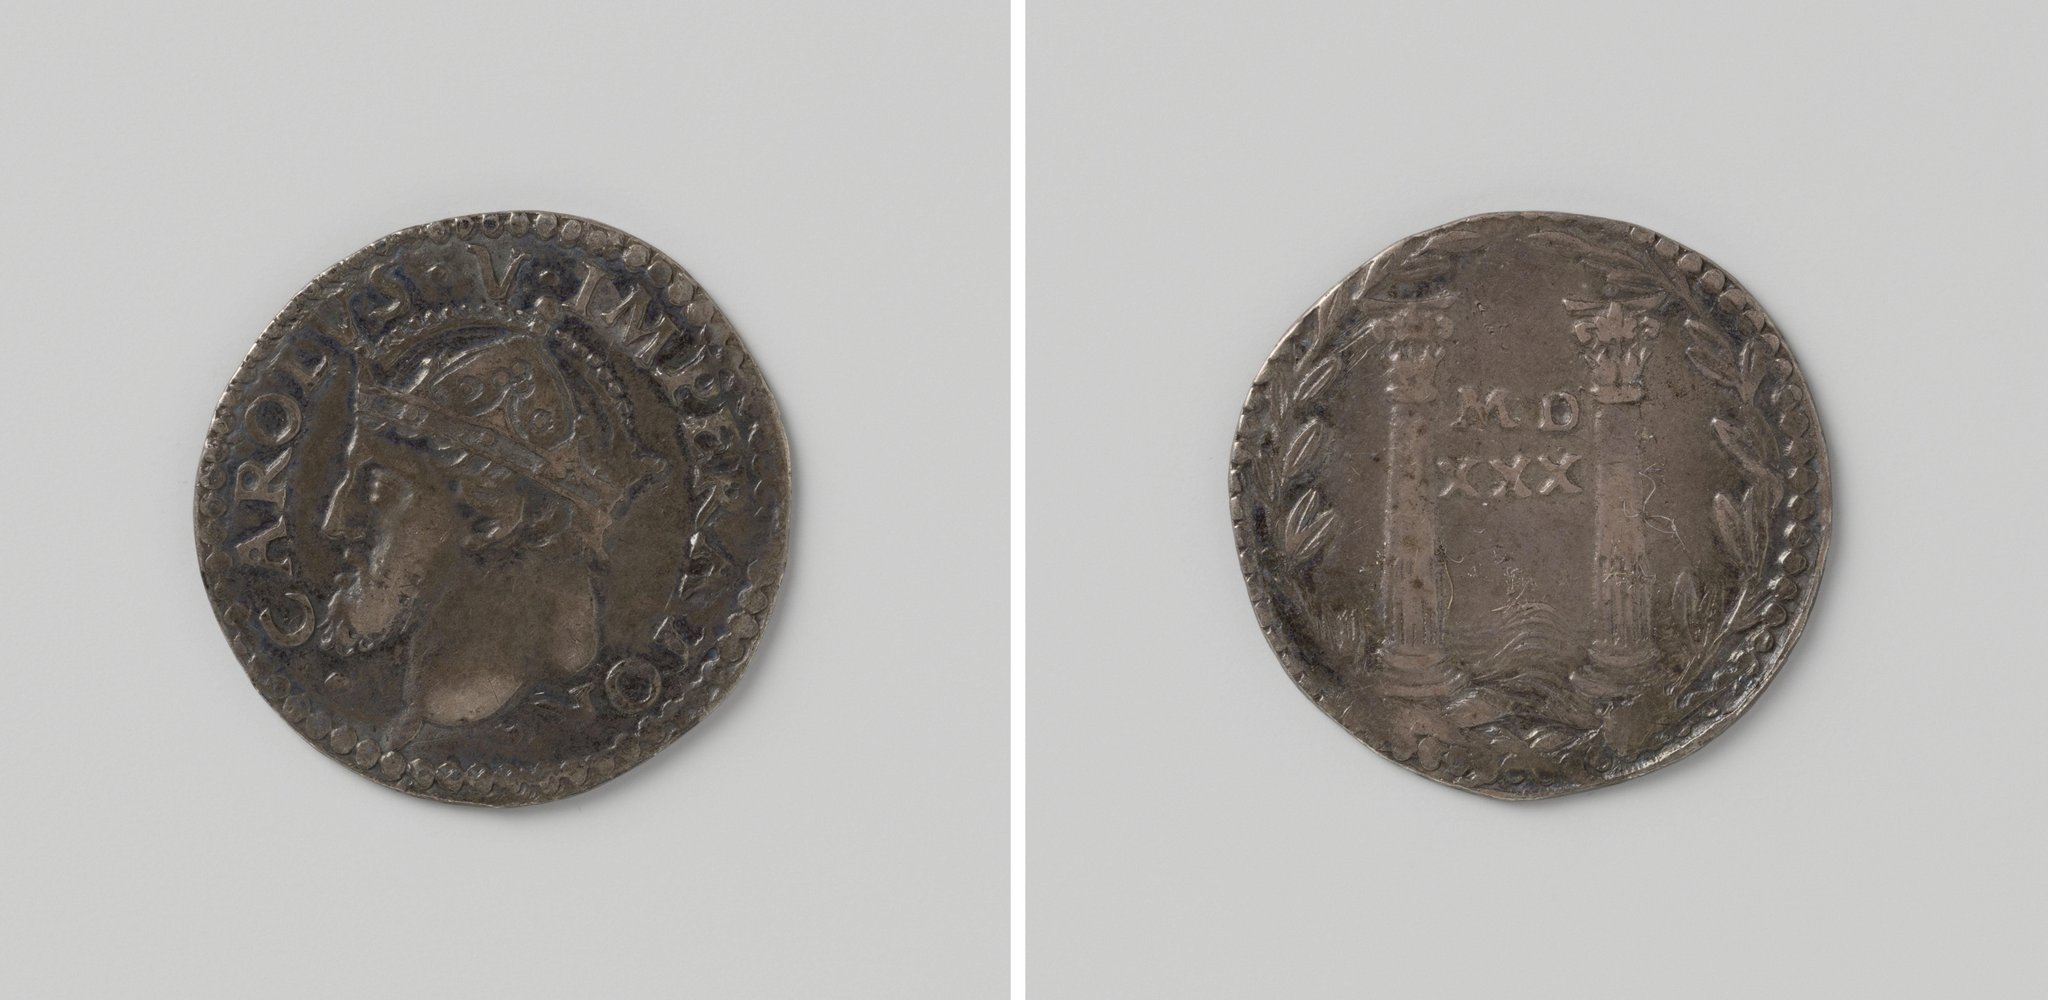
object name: strooipenning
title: Kroning van Karel V tot keizer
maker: Anonymous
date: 1530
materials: silver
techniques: striking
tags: ghent, charles v (holy roman emperor and king of spain)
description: Zilveren penning. Voorzijde: borststuk man met kroon binnen omschrift. Keerzijde: zuilen van Herkules met daartussen jaartal binnen lauwerkrans.